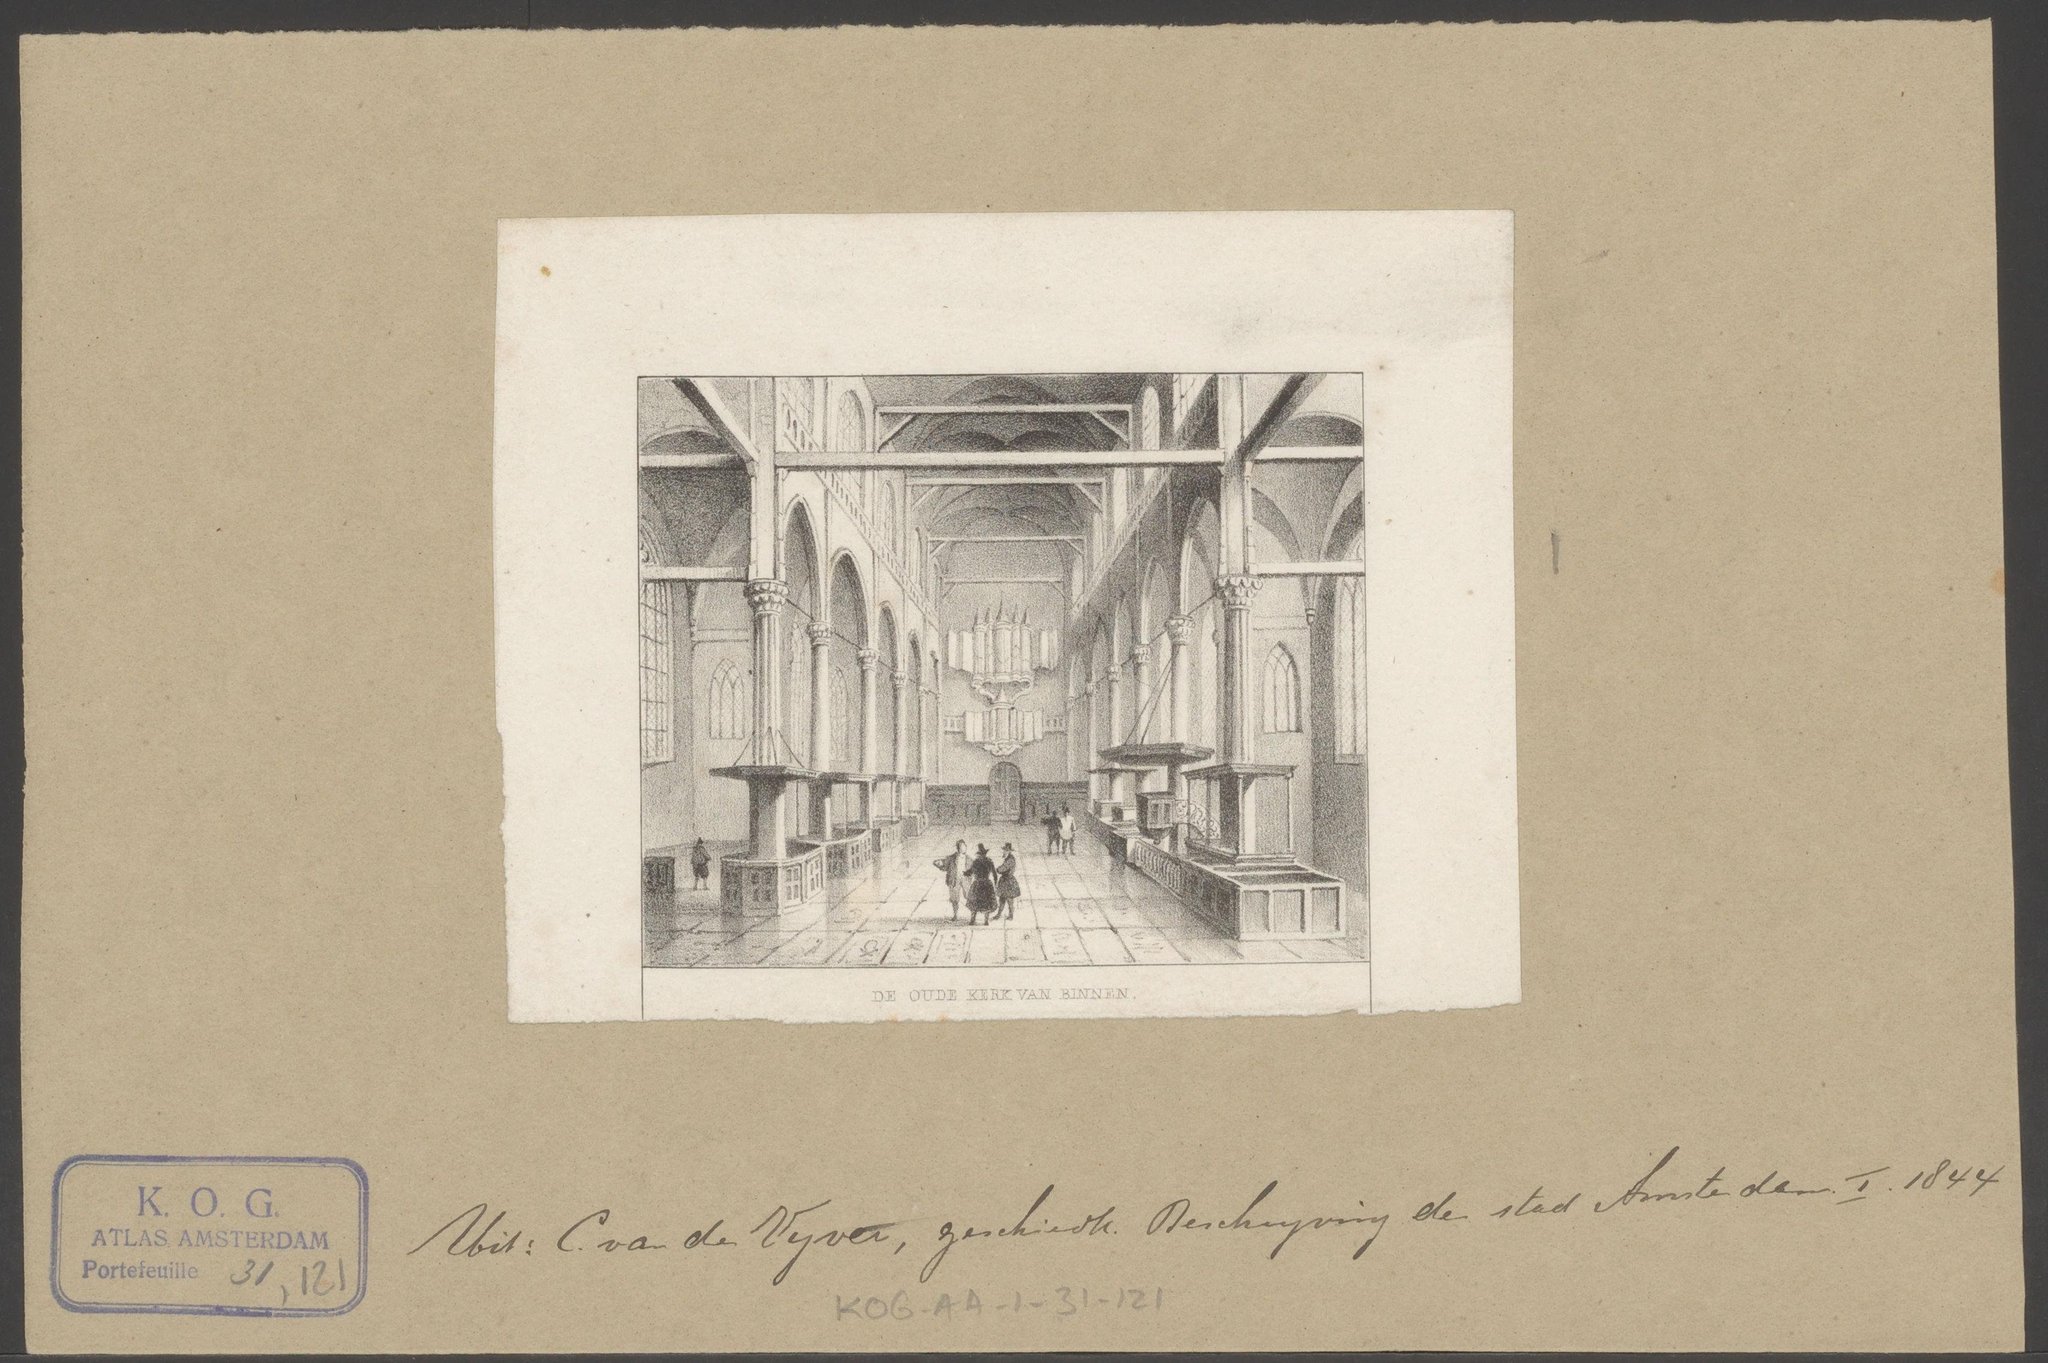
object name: book illustration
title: Gezicht in de Oude Kerk te Amsterdam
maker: Anonymous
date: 1844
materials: paper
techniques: lithograph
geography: amsterdam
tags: parts of church interior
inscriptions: collector's mark: ‘31.121’ Lugt 1641b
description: Prent uit: Vijver, C. van der. Geschiedkundige beschrijving der stad Amsterdam. Amsterdam: Gebroeders Diederichs, 1844.